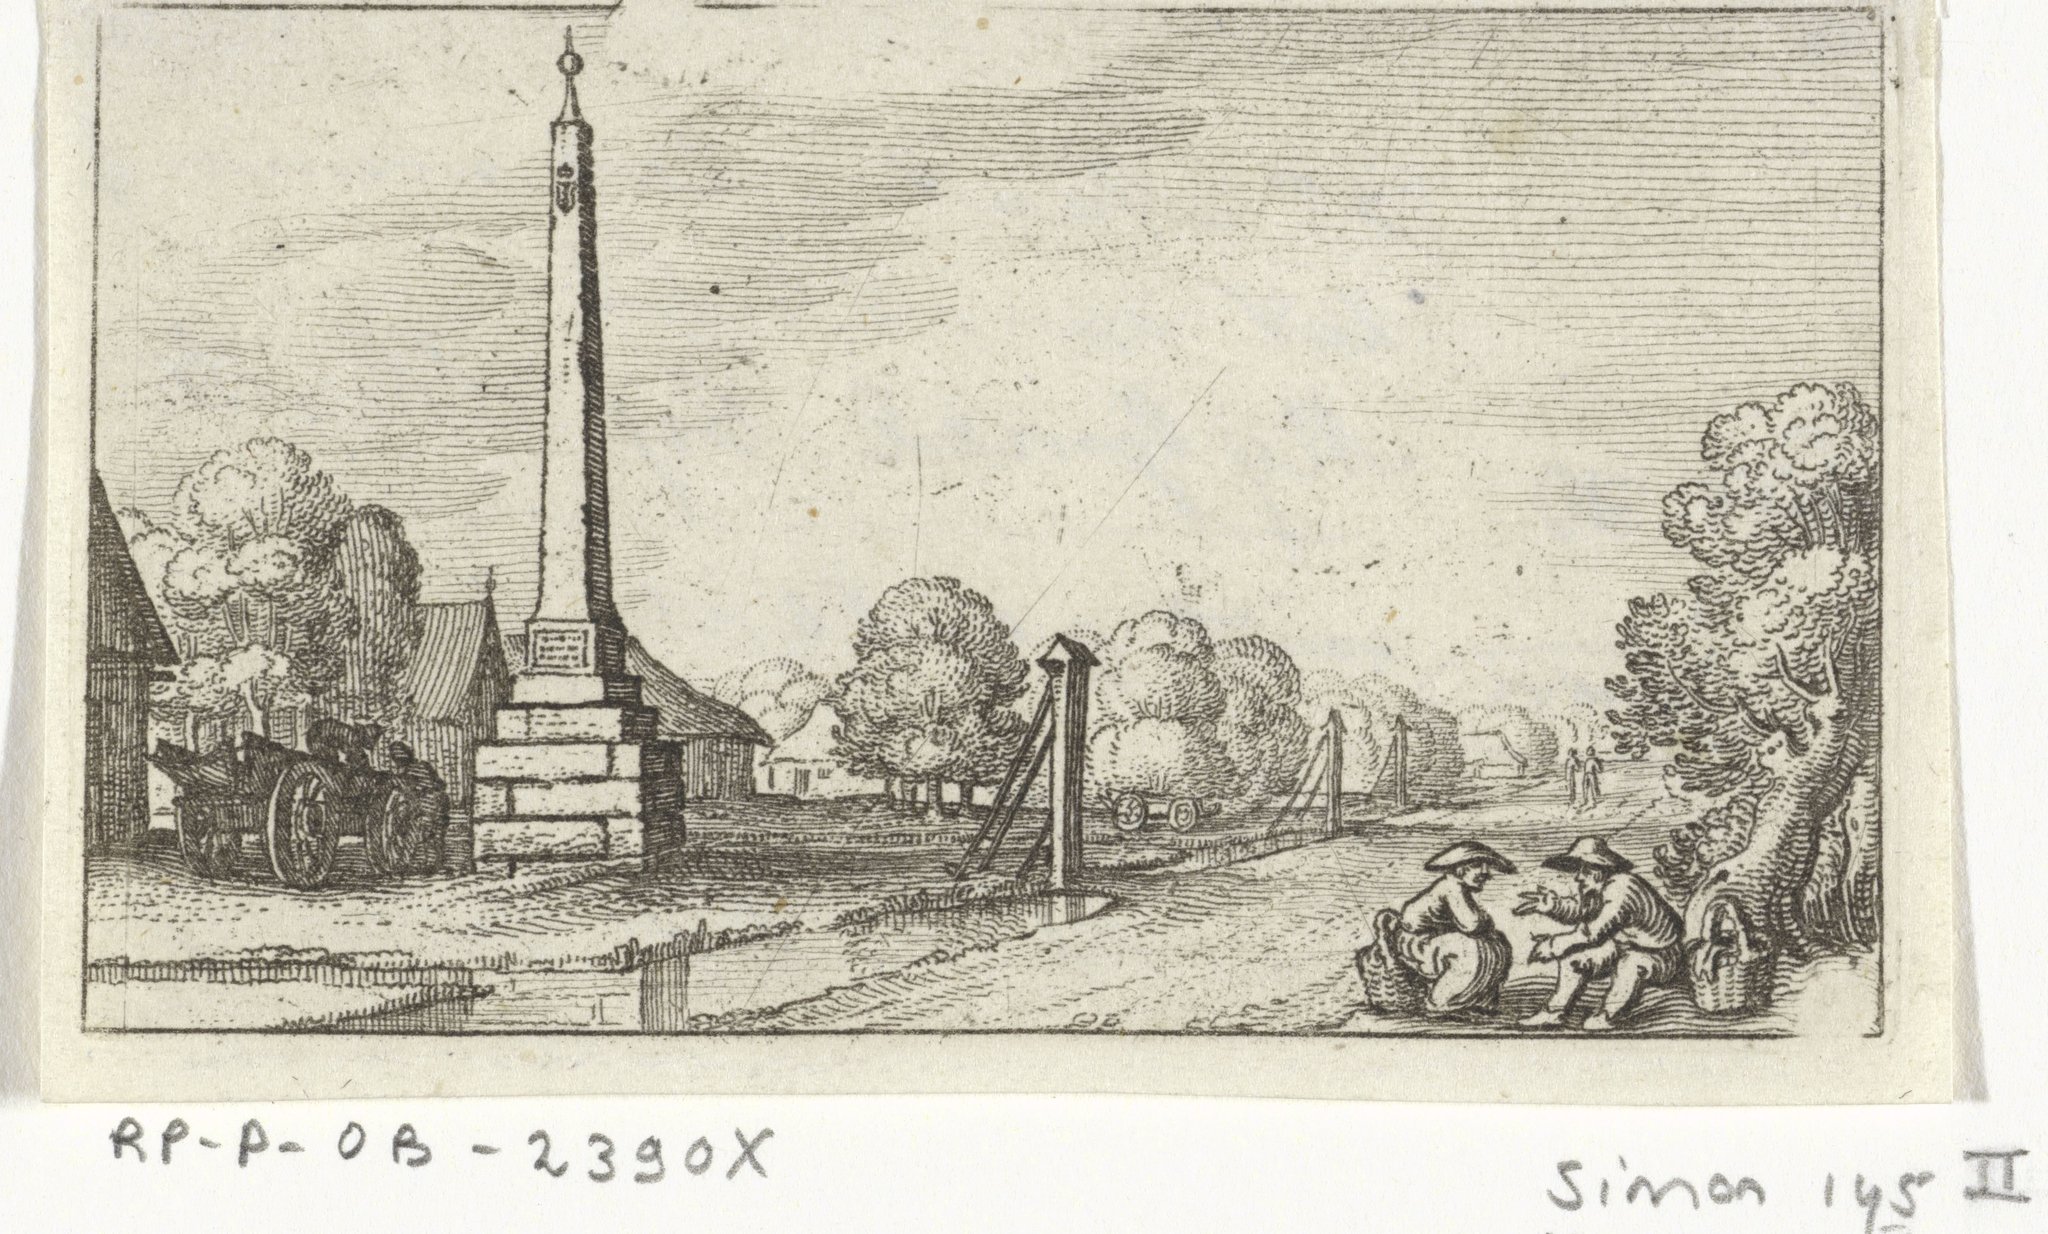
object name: print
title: Mijlpaal bij Sloten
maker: claes jansz. visscher (ii)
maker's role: draughtsman, print maker, publisher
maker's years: 1586-1652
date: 1612-1652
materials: paper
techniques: etching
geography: amsterdam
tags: milestone, conversation, dialogue; conversation piece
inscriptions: collector's mark: Lugt 2228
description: Gezicht op de mijlpaal te Sloten. Naast de mijlpaal een boerenkar en enkele lage huisjes. Rechts aan de rand van de weg zitten twee figuren te praten.